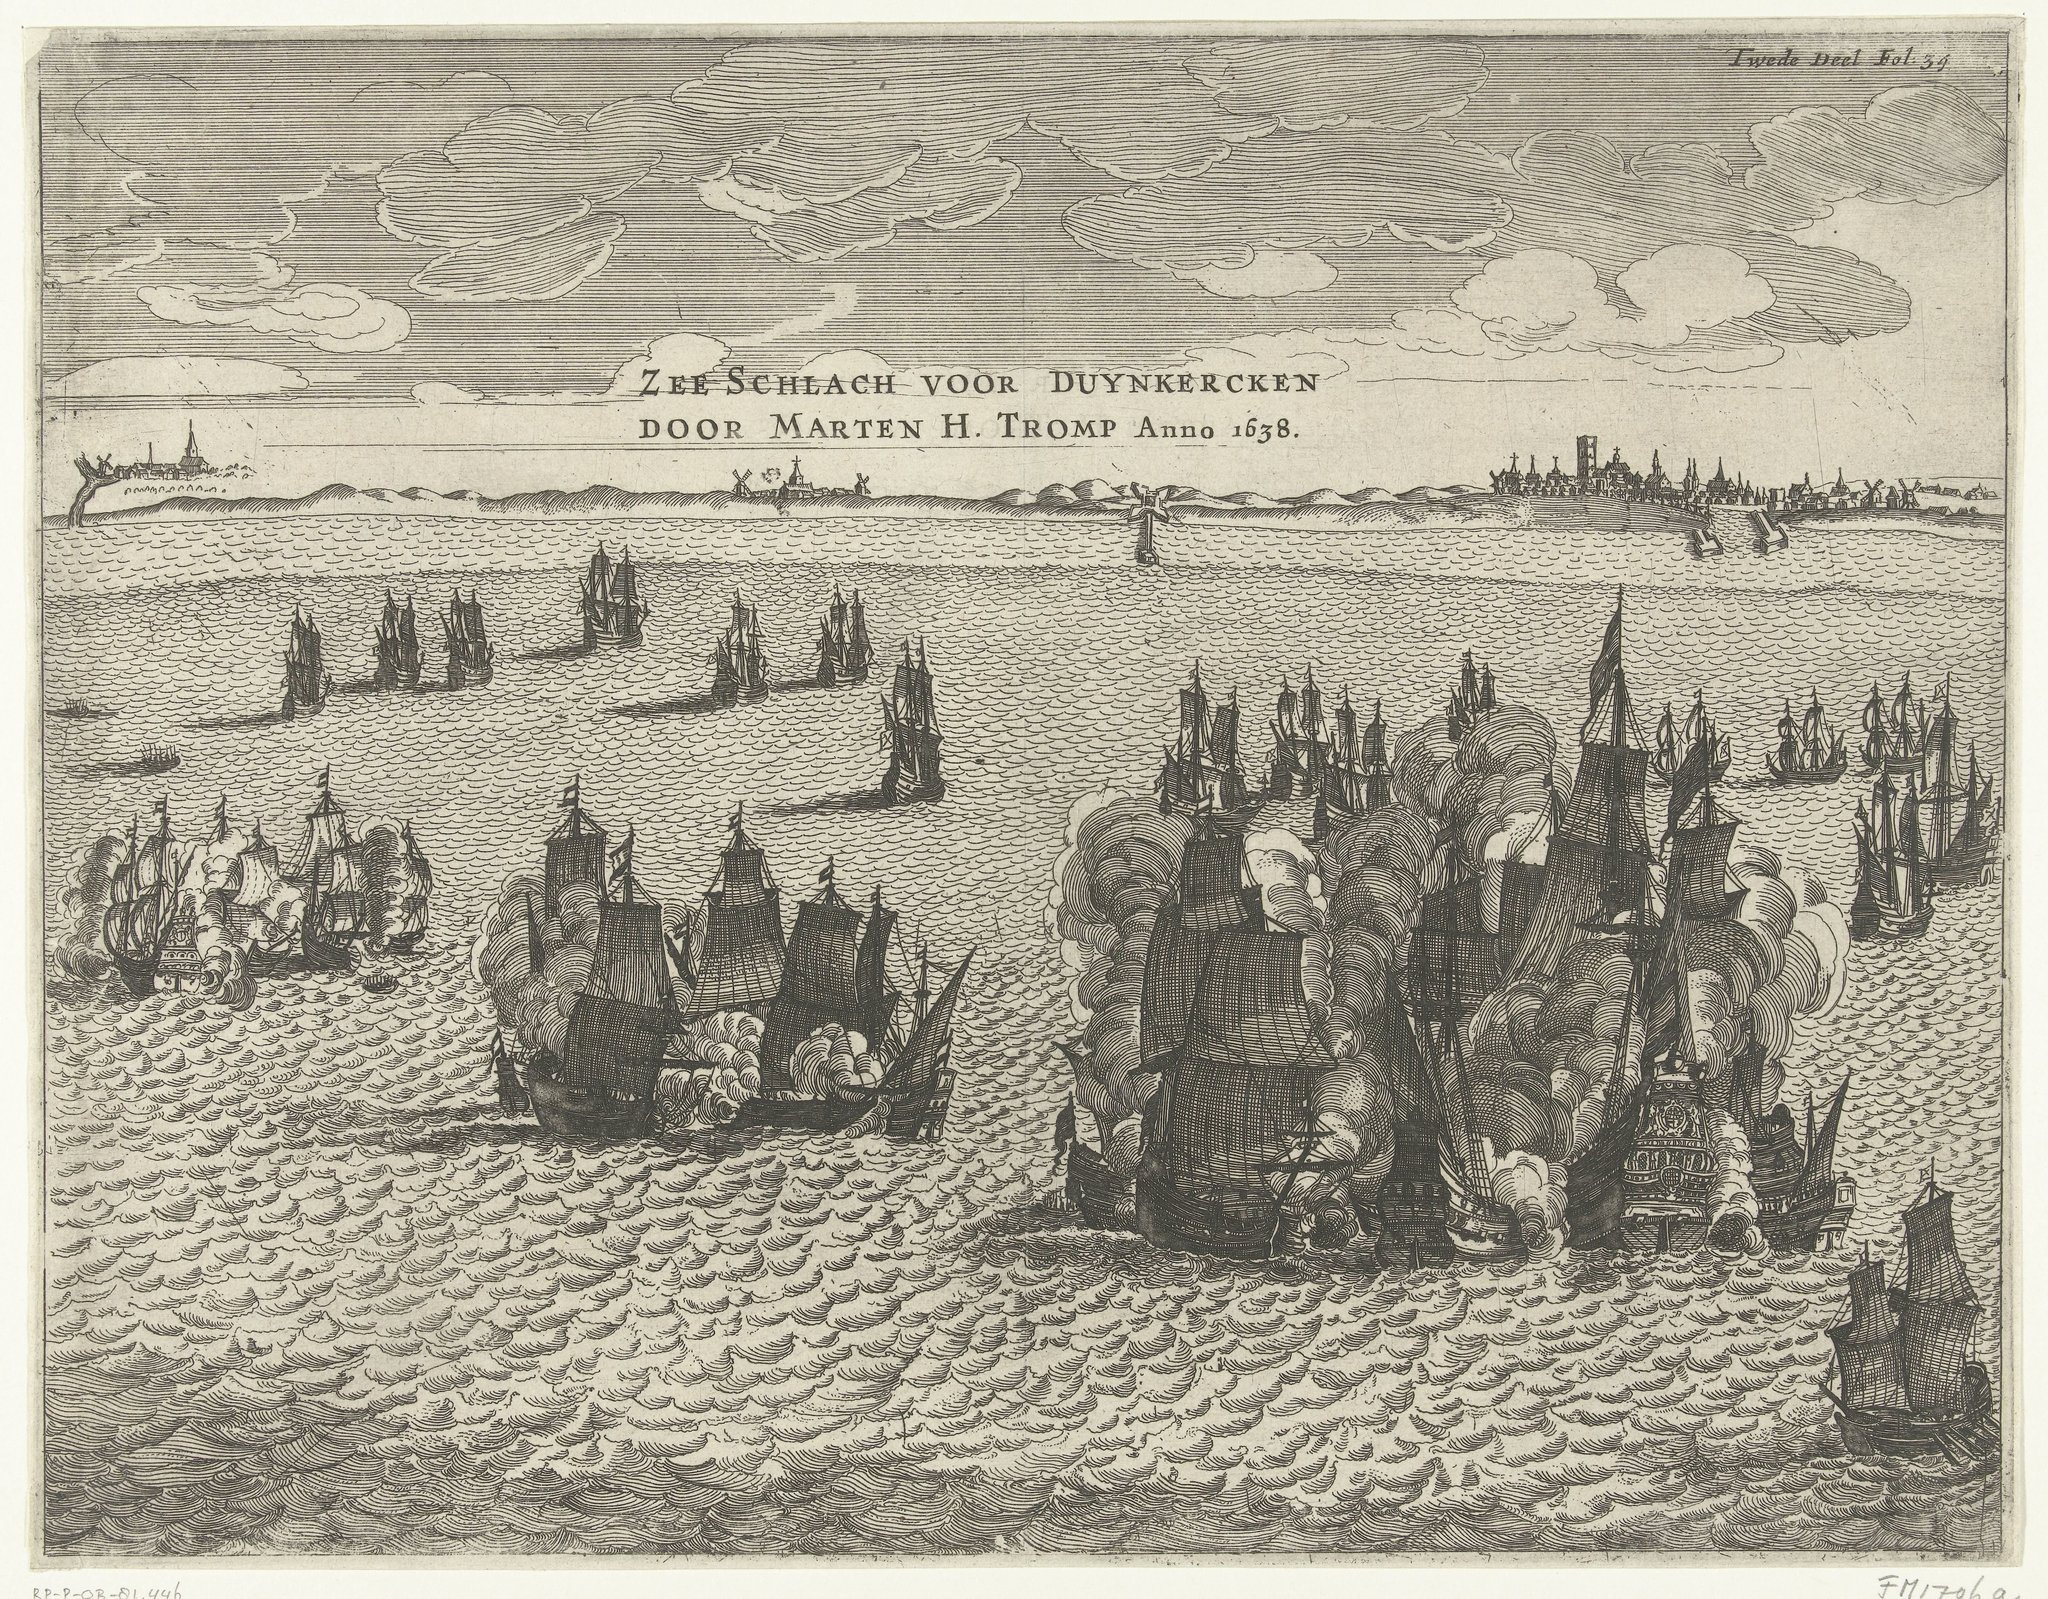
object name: print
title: Zee Schlach voor Duynkercken door Marten H. Tromp Anno 1638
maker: Anonymous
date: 1649-1651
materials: paper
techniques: etching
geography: northern netherlands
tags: maarten harpertszoon tromp, battle (+ naval force)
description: Zeeslag voor de kust bij Duinkerken, 18 februari 1639. Slag tussen de Staatse vloot onder Maarten Harpertszoon Tromp en een Spaanse vloot die de blokkade van de haven probeert te doorbreken. Gemerkt rechtsboven: Twede Deel Fol. 34.